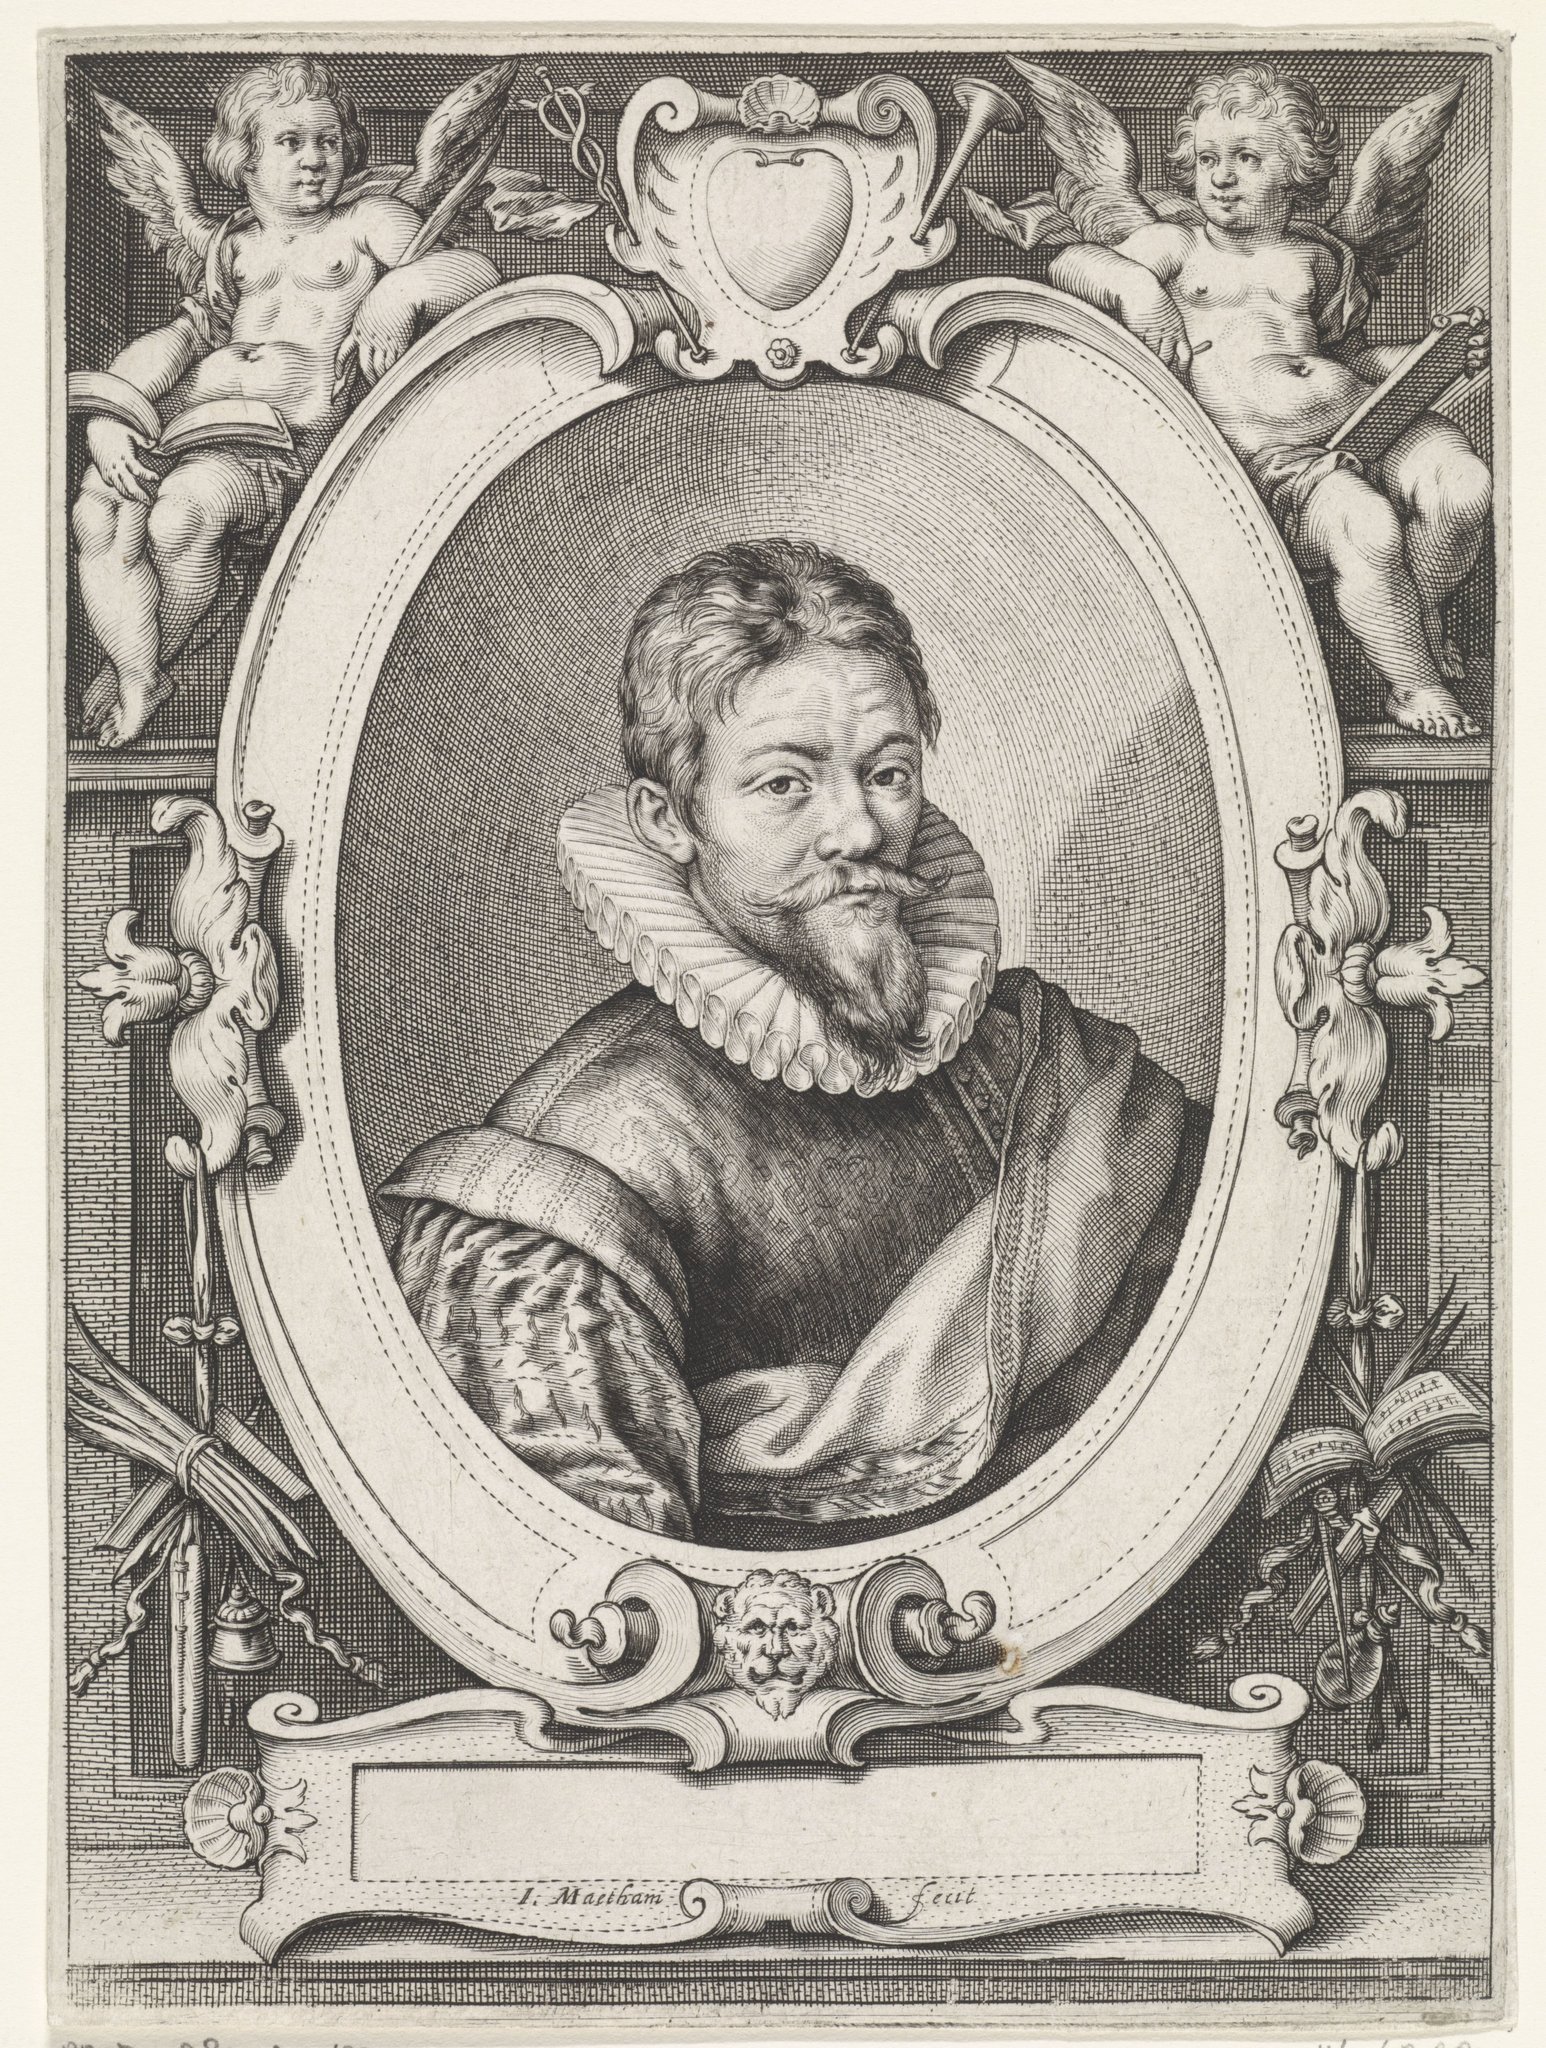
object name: print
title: Portret van Jan van de Velde (I)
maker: jacob matham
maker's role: draughtsman, print maker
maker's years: 1571-1631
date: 1602-1606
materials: paper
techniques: engraving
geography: haarlem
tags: haarlem, jan van de velde (i), writing and letters (+ portrait of scholar, scientist), historical persons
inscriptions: collector's mark: Lugt 2228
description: Portret van de Haarlemse kunstenaar Jan van de Velde I (1569-1623).